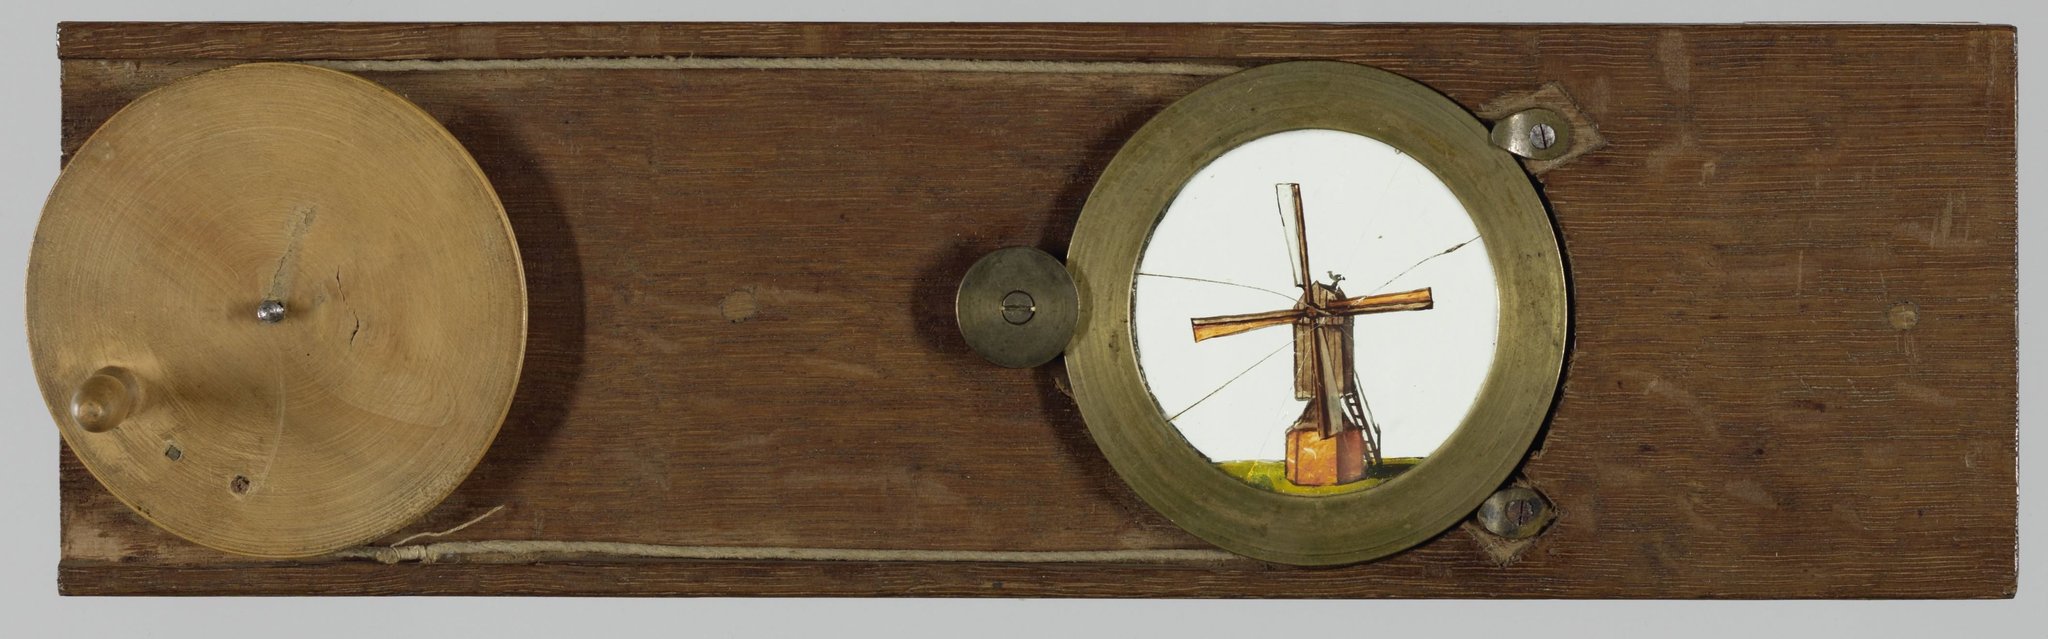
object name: lantern slide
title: Molen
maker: Anonymous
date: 1700-1790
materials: glass, wood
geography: netherlands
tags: windmill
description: Eikenhouten plank met daarin een rond toverlantaarnplaatje van een molen. De wieken van de molen zijn op een apart glasplaatje geschilderd, dat d.m.v. een wieltje en een touwtje los van de andere glasplaat gedraaid kan worden. Hierdoor ontstaat de indruk dat de molen draait.